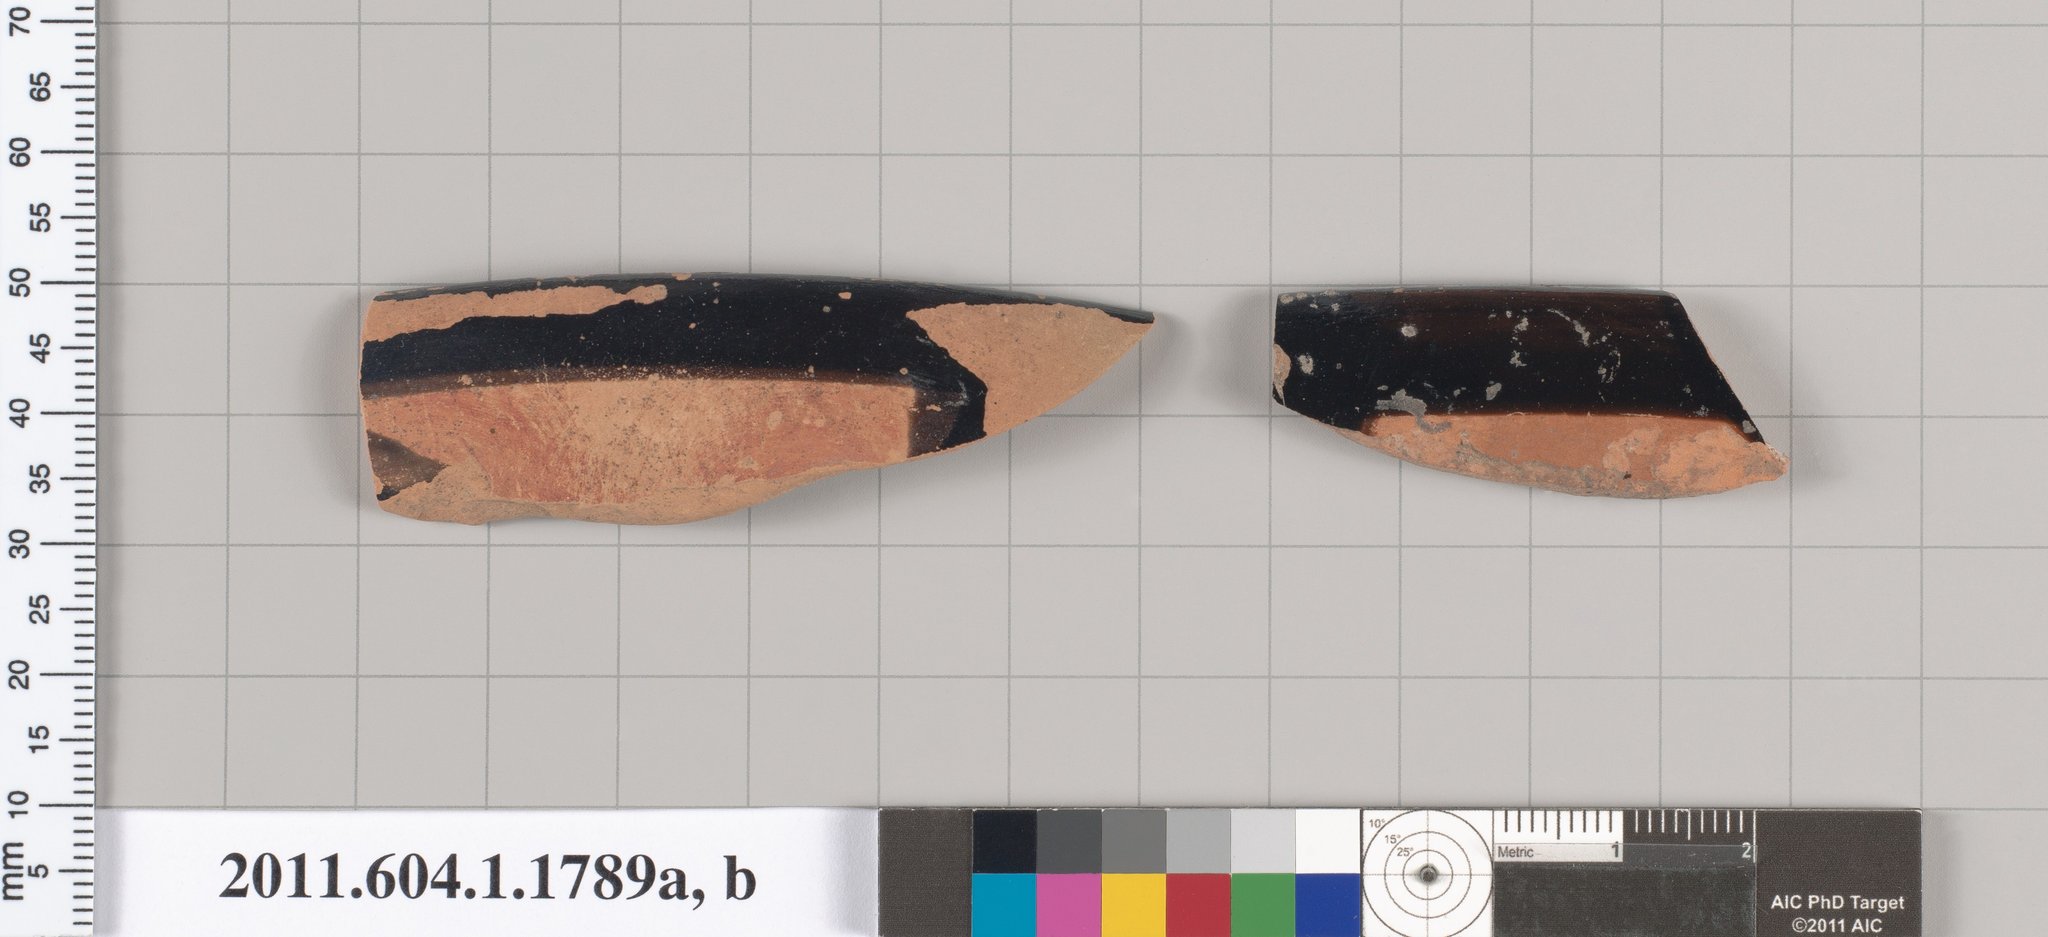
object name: kylix fragment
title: Terracotta rim fragments of kylikes(drinking cups)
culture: greek, attic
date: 500-401 BCE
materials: terracotta